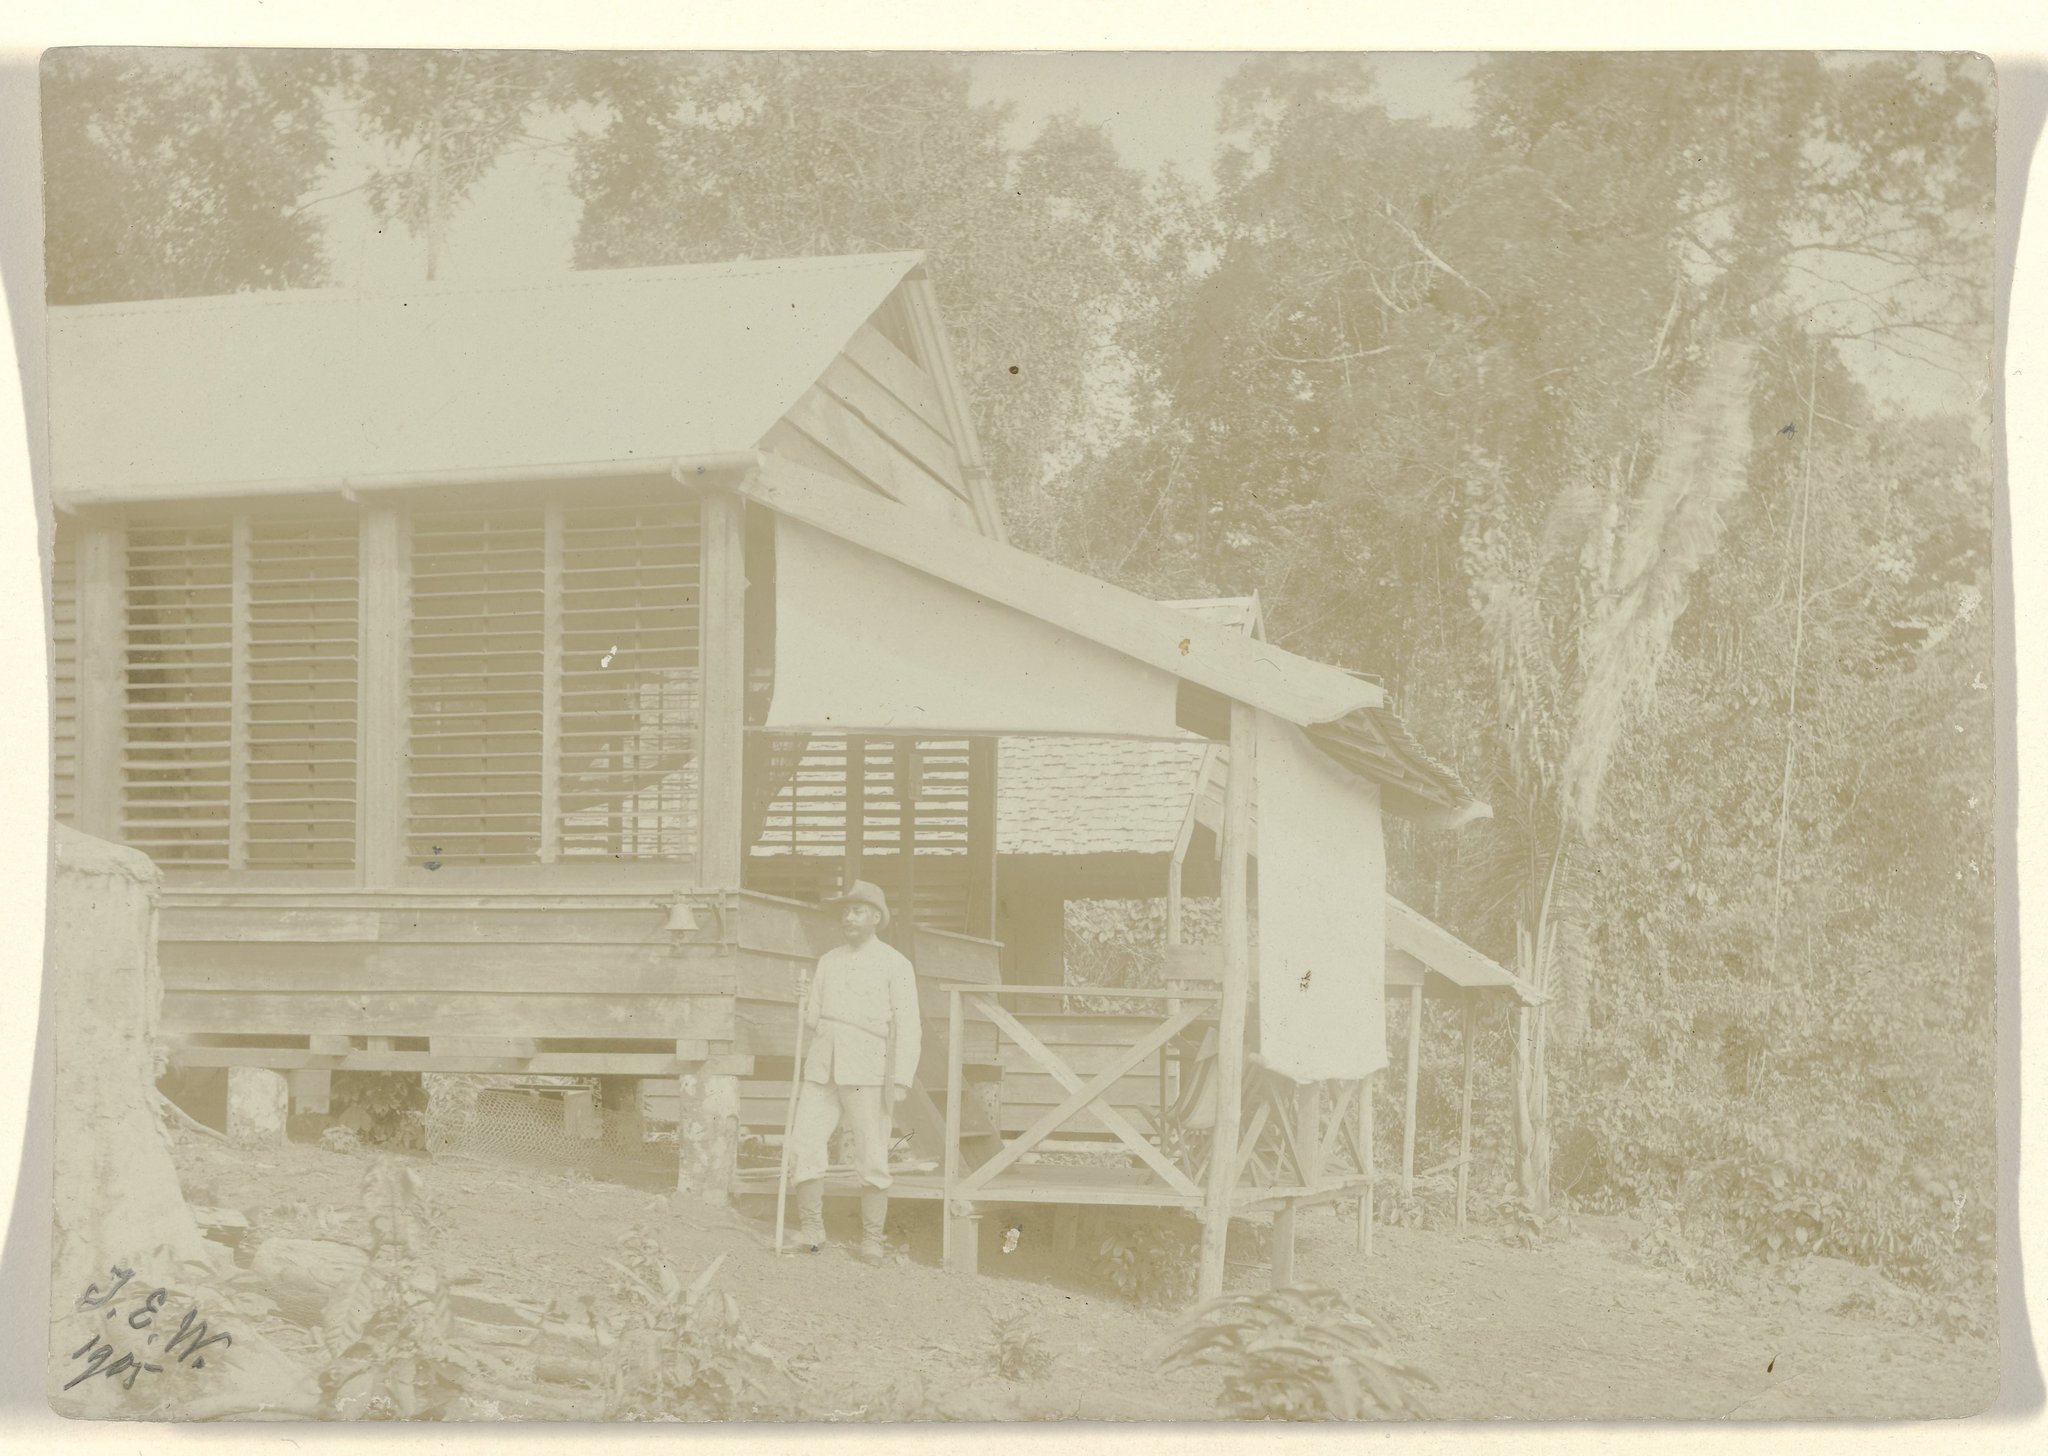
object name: photograph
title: Jacob Evert Wesenhagen voor zijn dienstwoning in het kamp bij de Maäboberg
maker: jacob evert wesenhagen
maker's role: amateurfotograaf, arts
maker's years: 1862-1924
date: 1902-1905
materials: photographic support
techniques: photography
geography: suriname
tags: jacob evert wesenhagen, railway, train, suriname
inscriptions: annotation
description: Zelfportret van Jacob Evert Wesenhagen, kampgeneesheer, voor zijn woning op de Maäbo Heuvel. Bij de aanleg van de Lawaspoorweg in Suriname in de jaren 1903-1912. Onderdeel van een groep objecten afkomstig van de familie Wesenhagen in Suriname.